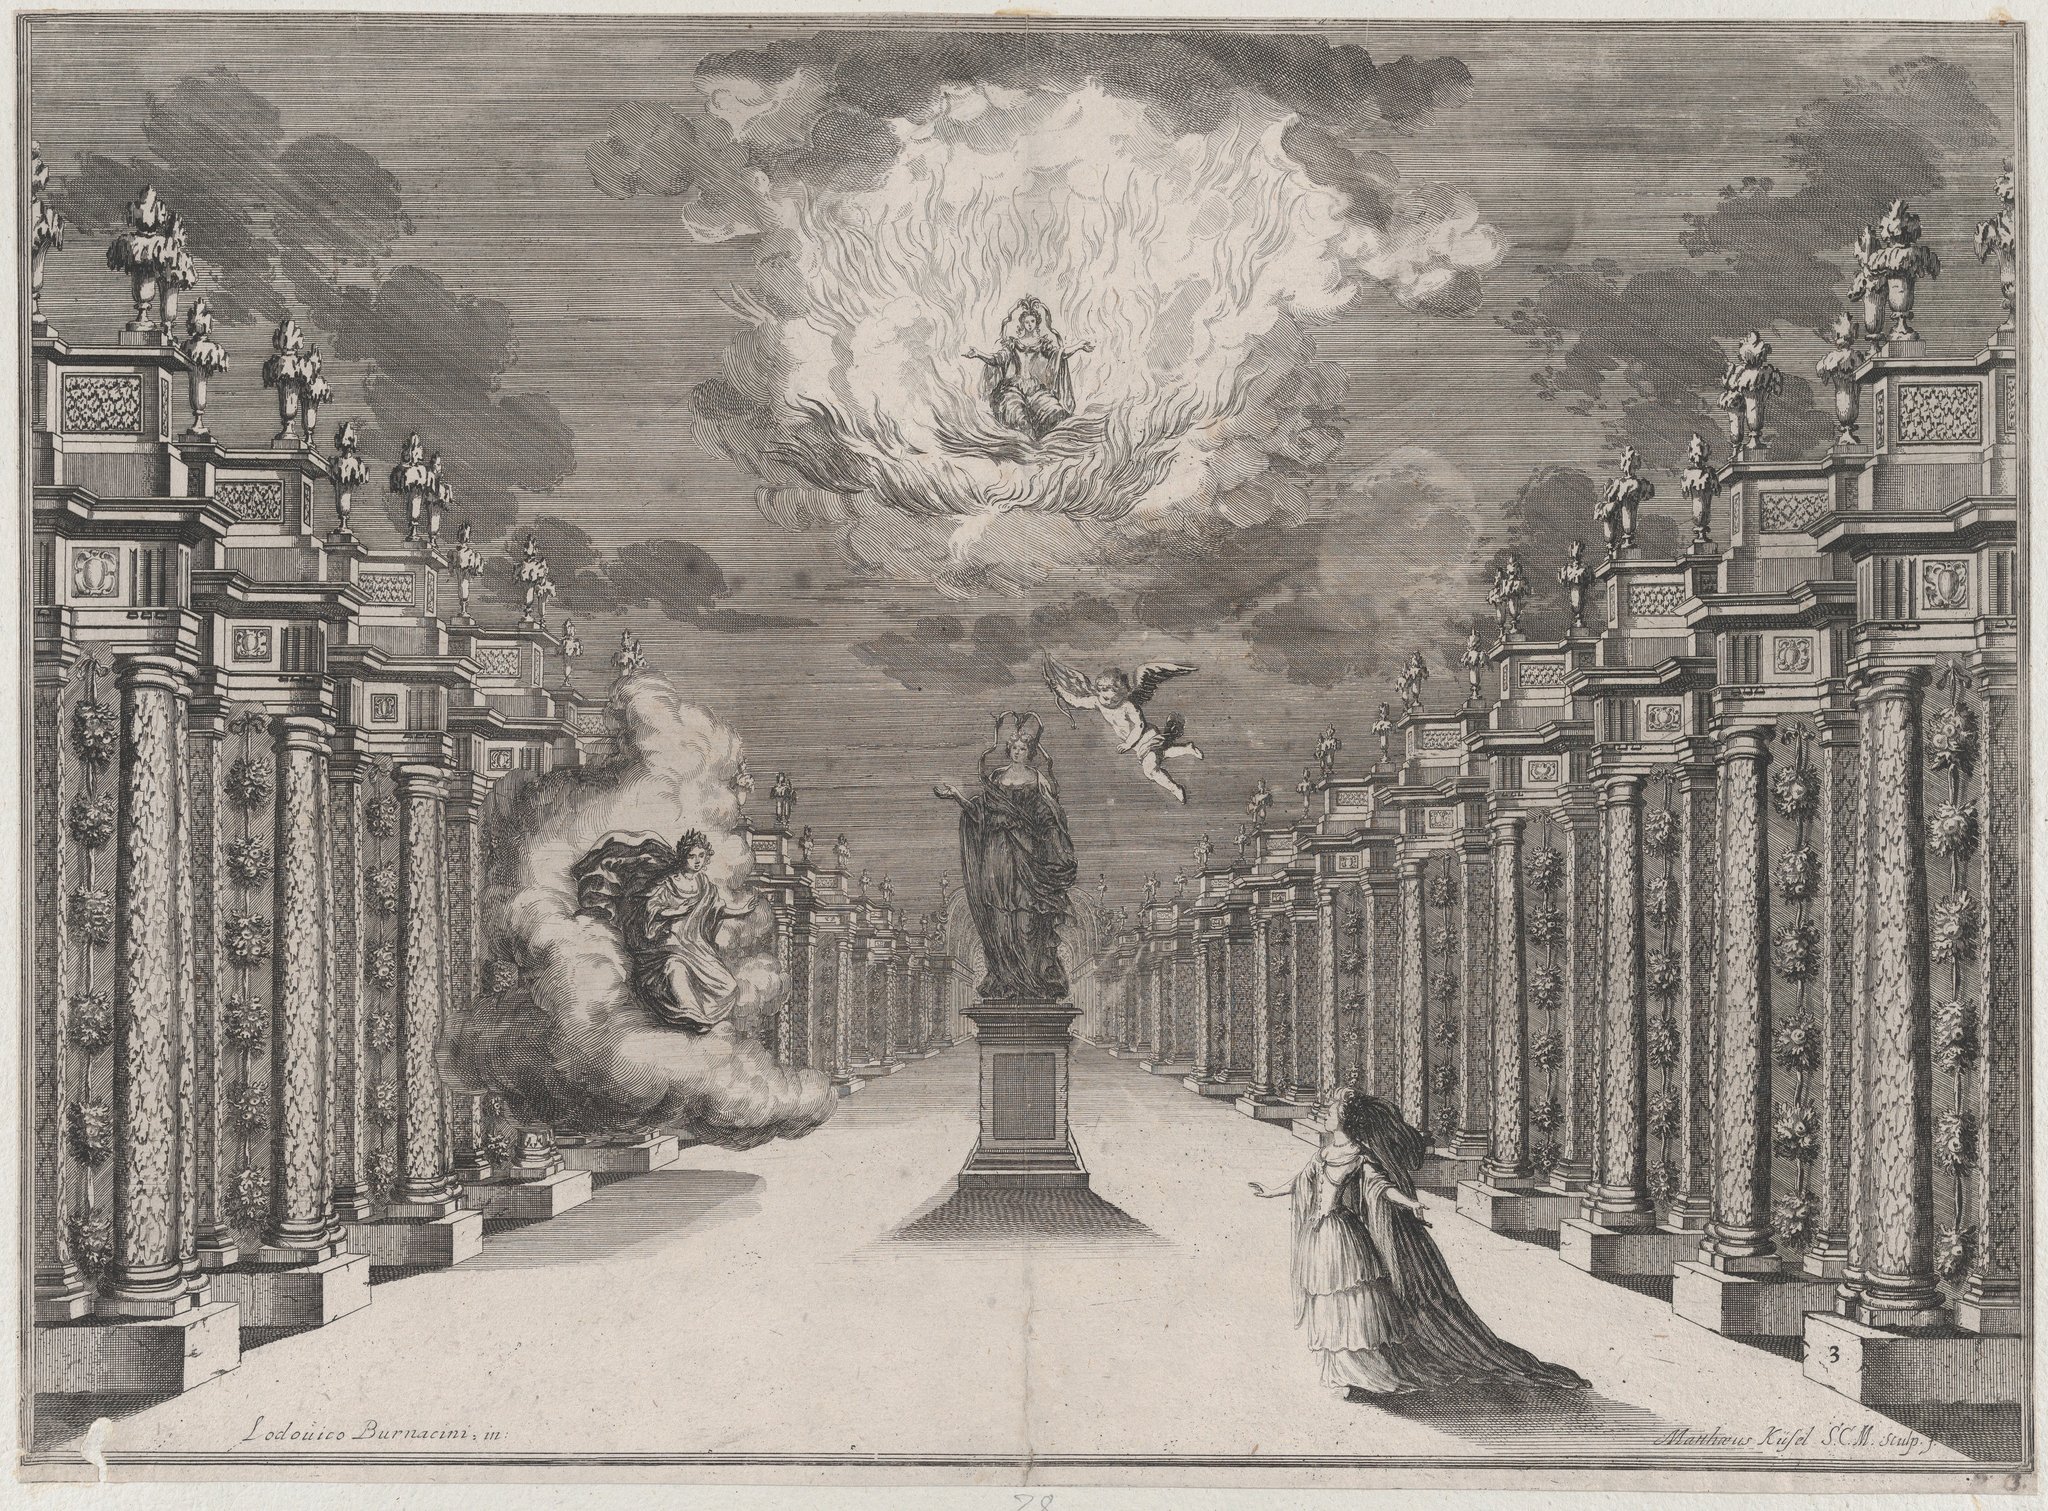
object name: print, fete, ornament architecture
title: A woman standing on the right side of a road lined with columns; at center a statue of a female with cupid flying nearby; to the left, a woman emerging from the clouds as another sits among flames above; set design from 'Il Fuoco Eterno'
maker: mathäus küsel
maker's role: artist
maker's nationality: german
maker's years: 1621-1682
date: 1674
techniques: etching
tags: columns,women,cupid